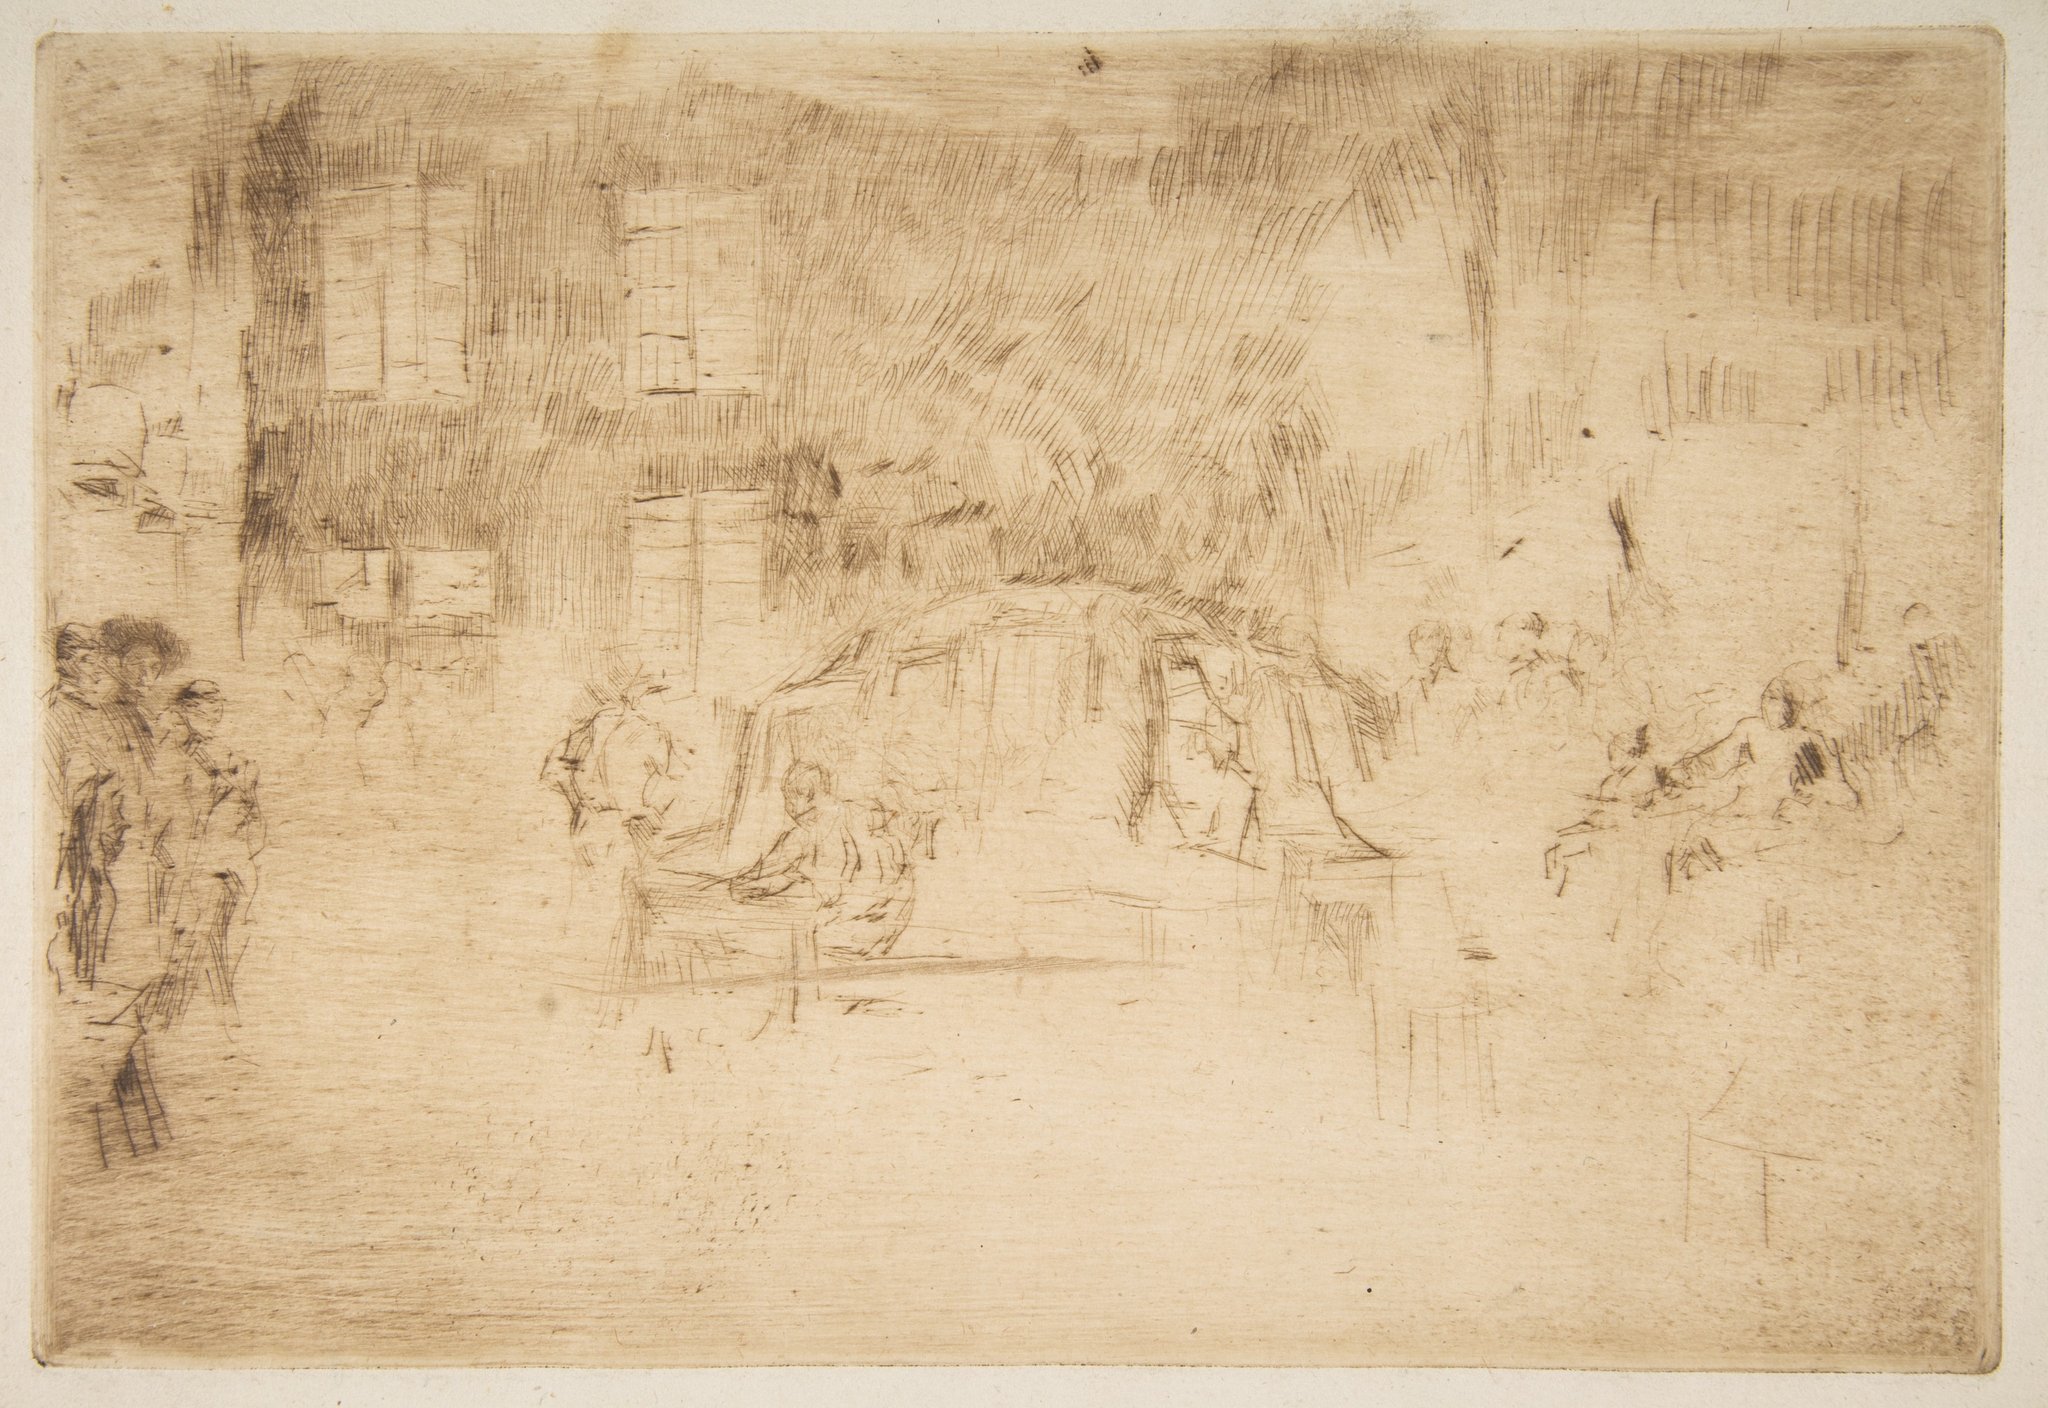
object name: print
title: Glass Furnace: Murano (Murano – Glass Furnace)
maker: james mcneill whistler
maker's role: artist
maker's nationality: american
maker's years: 1834-1903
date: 1879-1880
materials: ink, paper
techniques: drypoint, etching, printing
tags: human figures